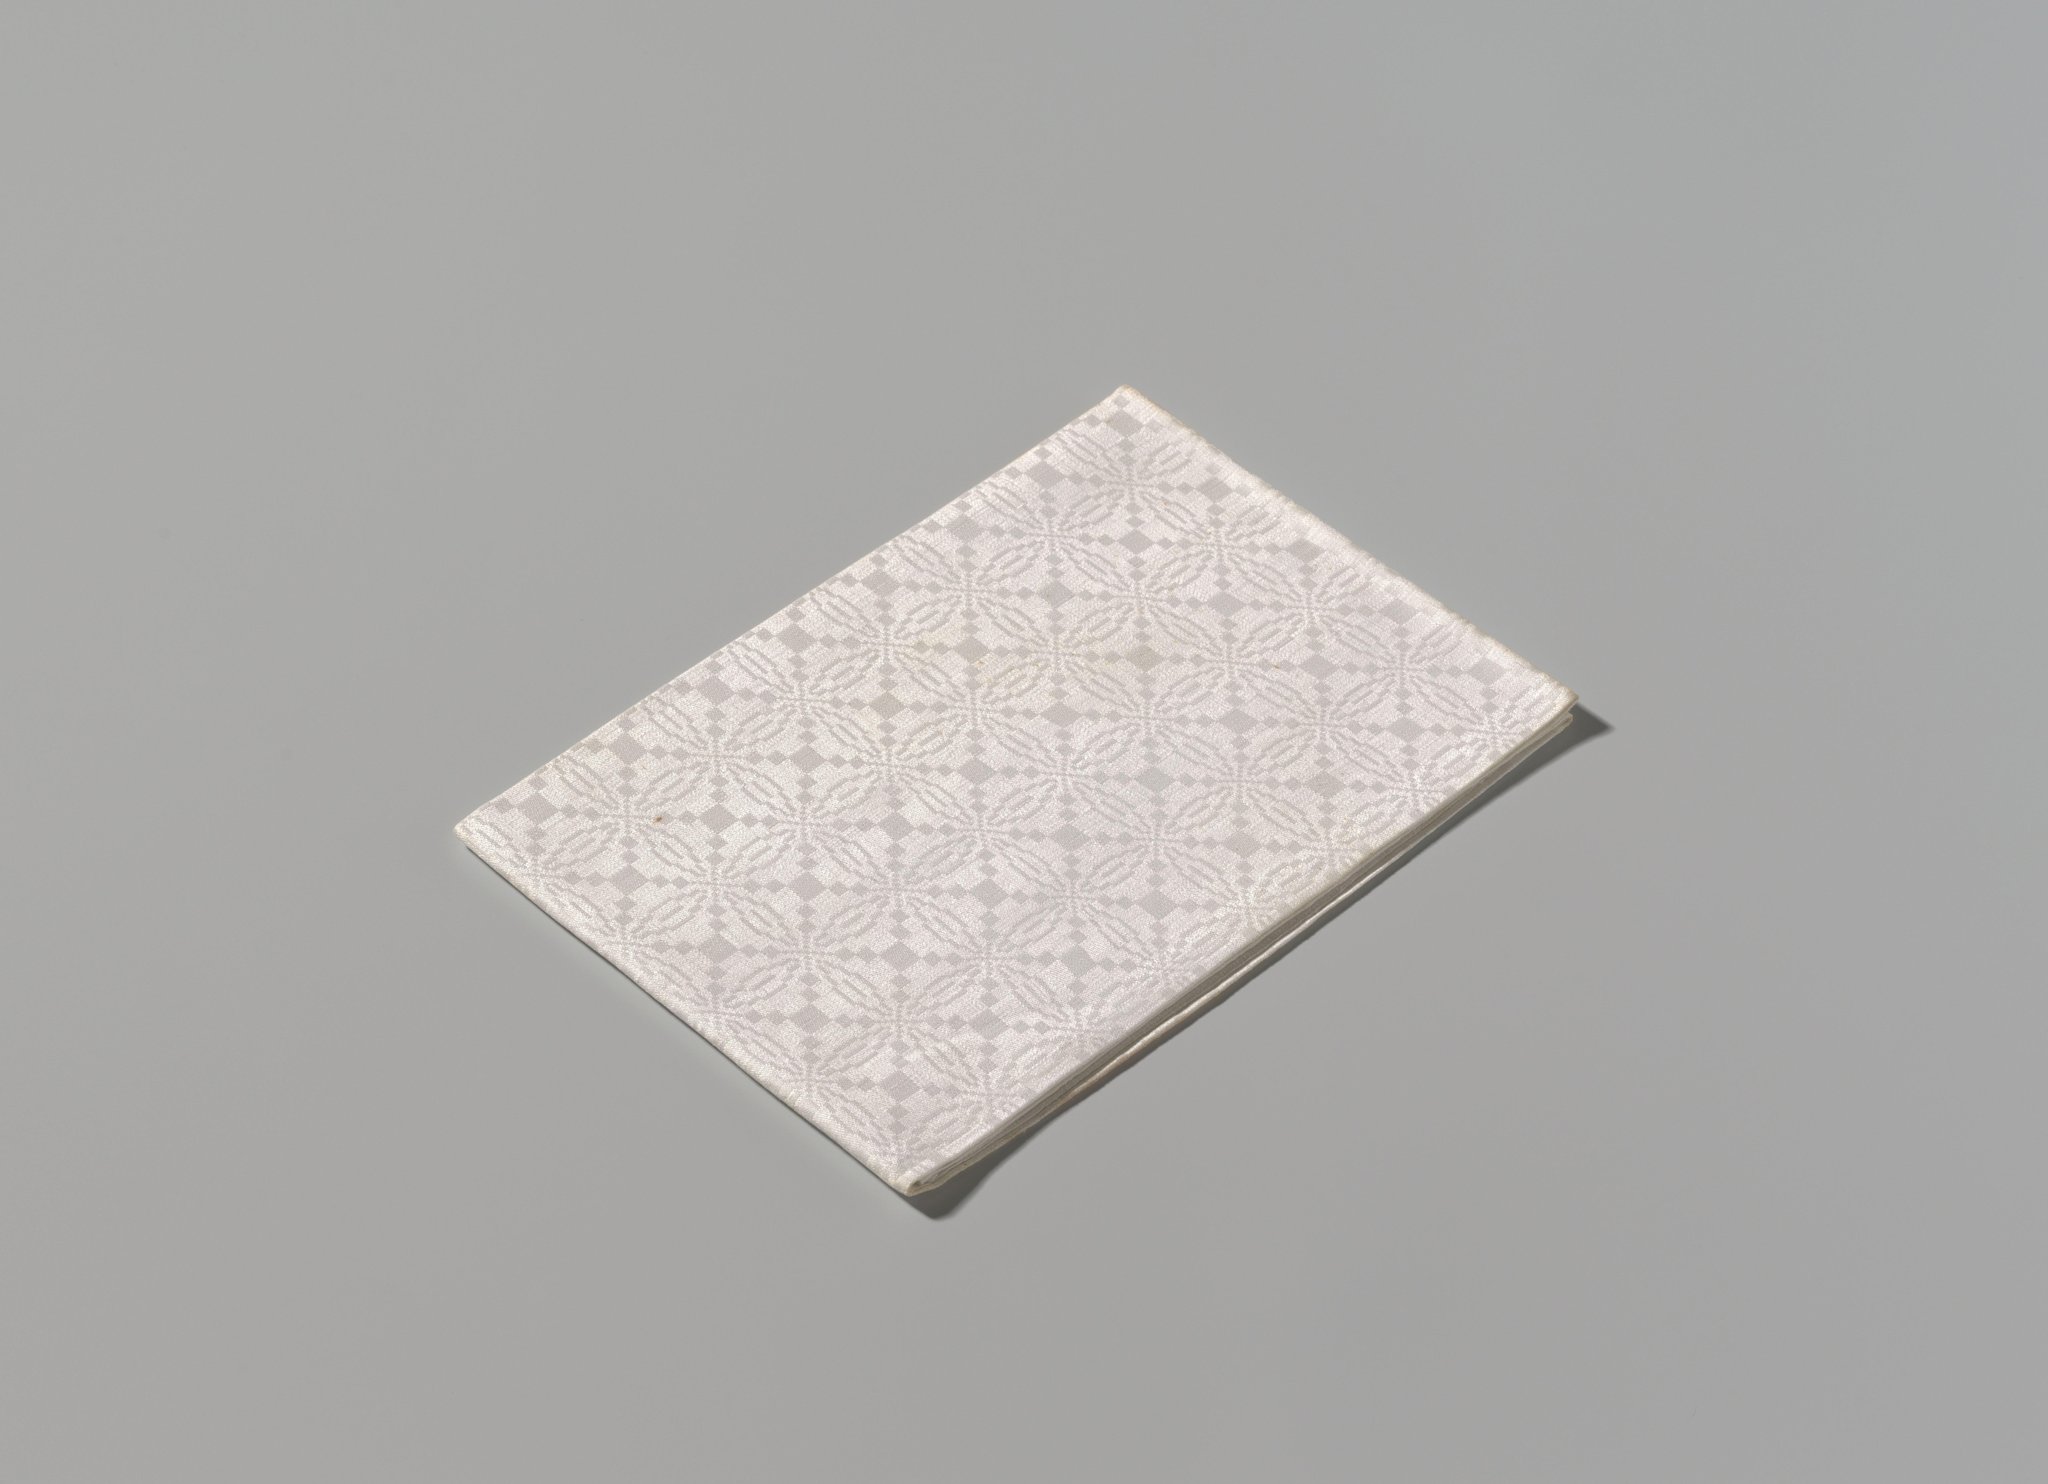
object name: napkin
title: Servet van linnen met pellenpatroon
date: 1620-1660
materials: linen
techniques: peeled fabric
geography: northern netherlands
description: Wit linnen servet met een pellen patroon. Merk AVR HB.